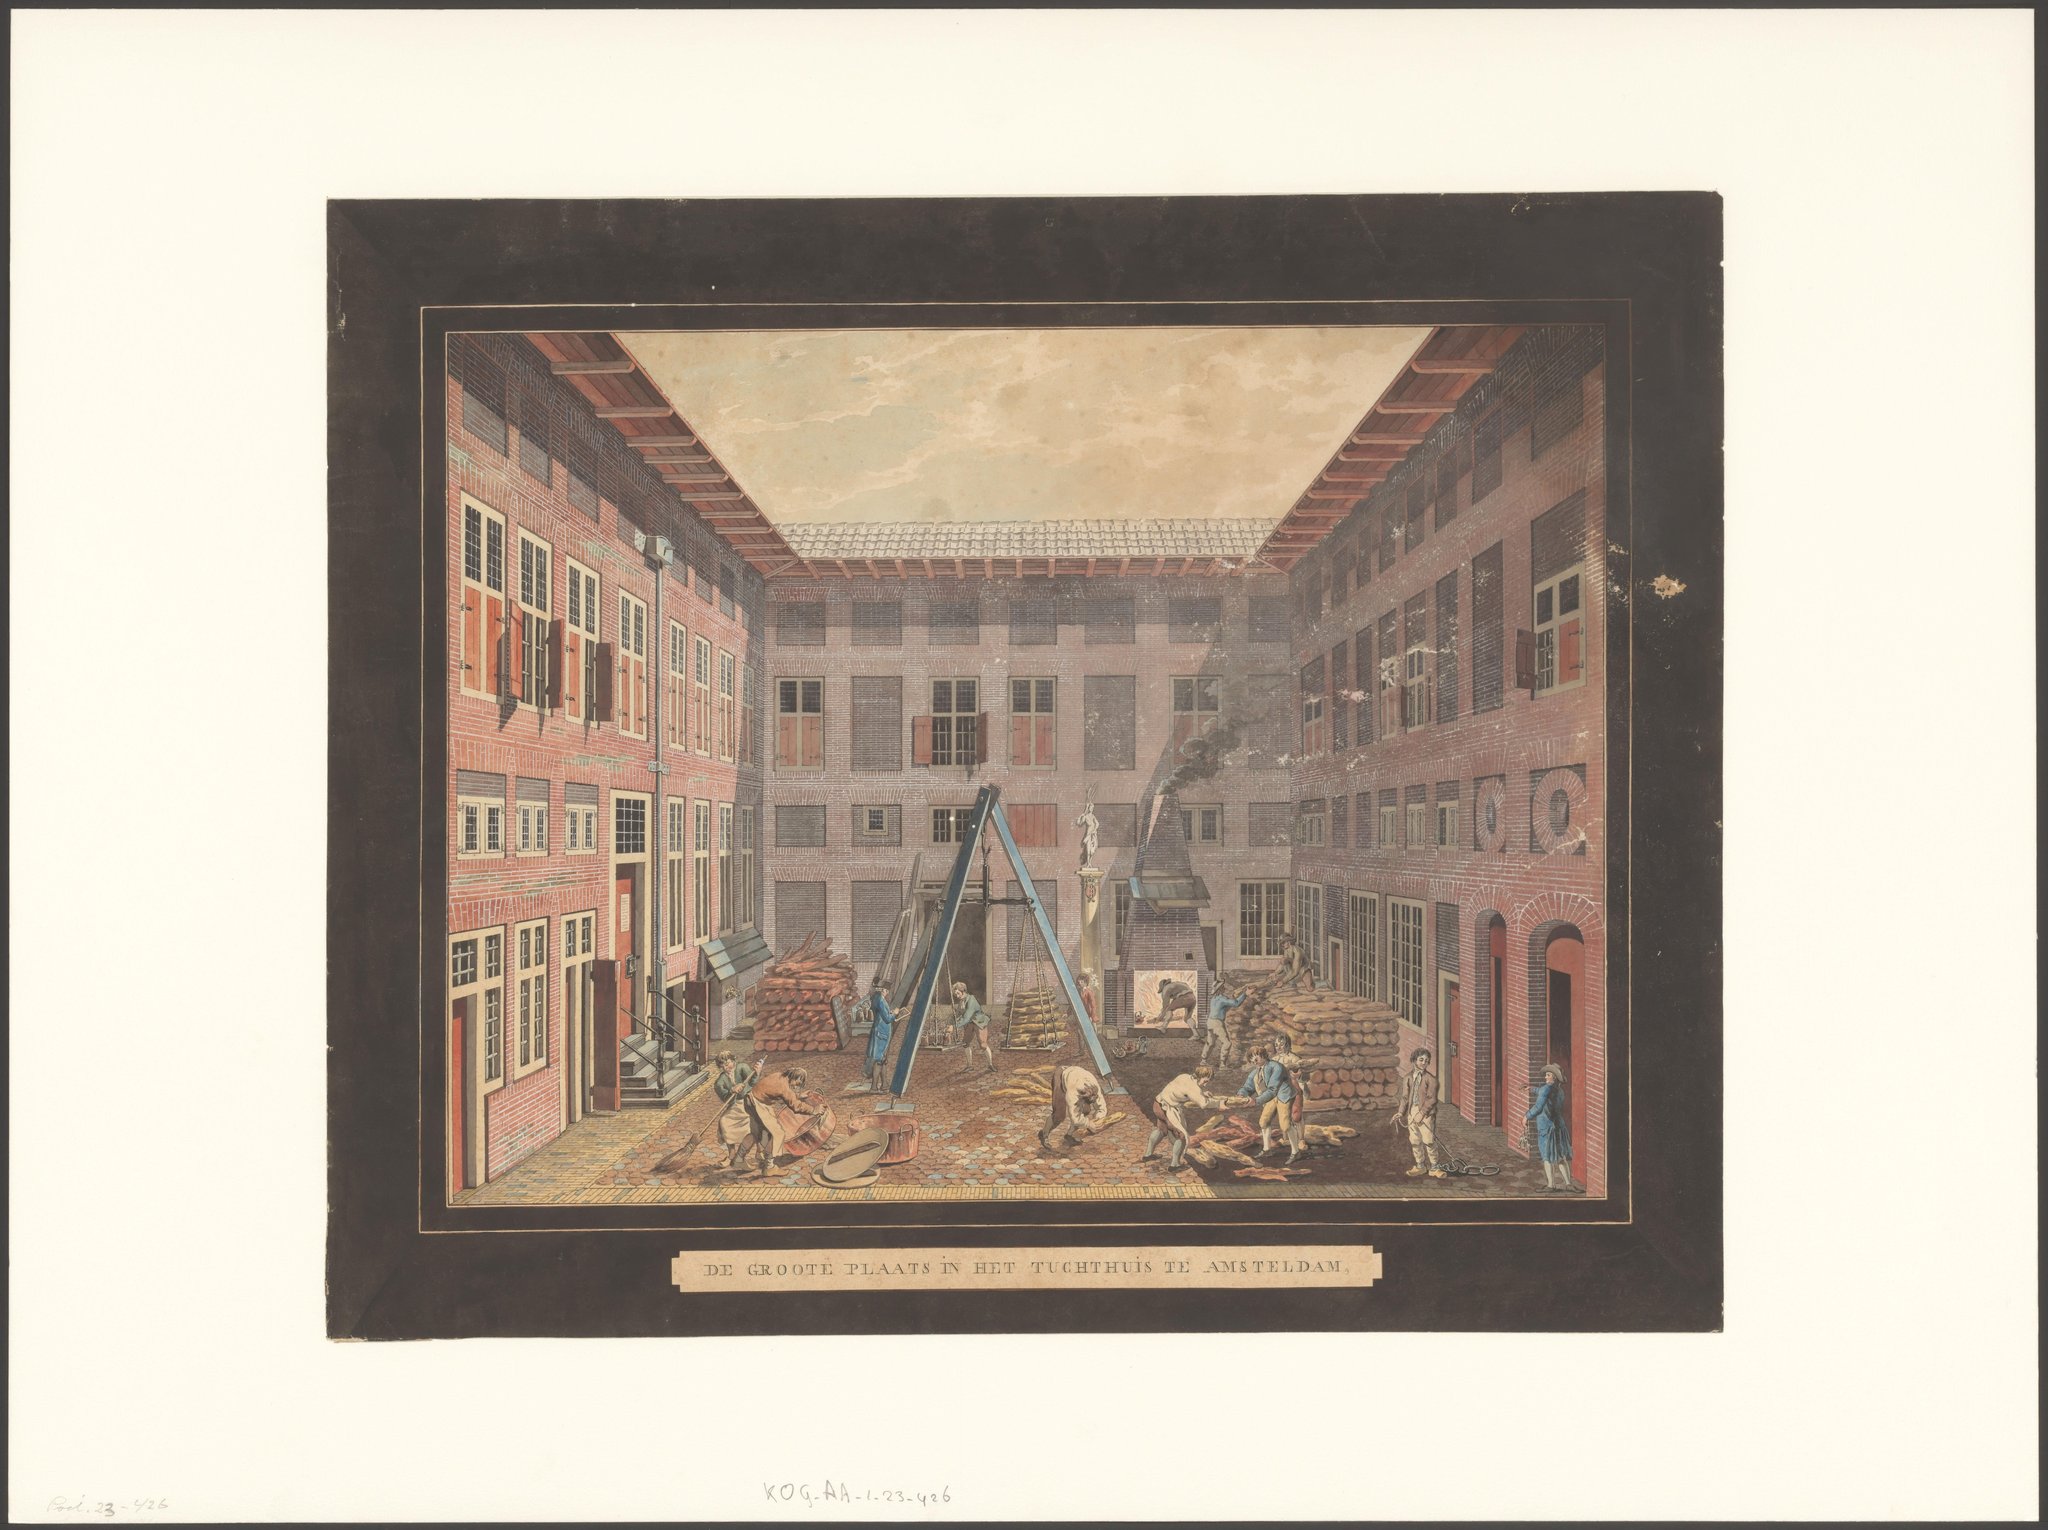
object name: drawing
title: Gezicht op de binnenplaats van het tuchthuis aan de Kostverlorenvaart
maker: Anonymous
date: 1800-1899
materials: paint, gouache, ink, paper, pencil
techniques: brush, pen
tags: city-view in general; 'veduta', courtyard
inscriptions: inscription: ‘Port. 23-426’, inscription: ‘De Groote Plaats in het Tuchthuis te Amsteldam’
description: Onderwerpsrubriek binnen de Atlas Amsterdam: Handvesten, Keuren, enz.; Rechtswezen (incl. gevangenissen, enz.).